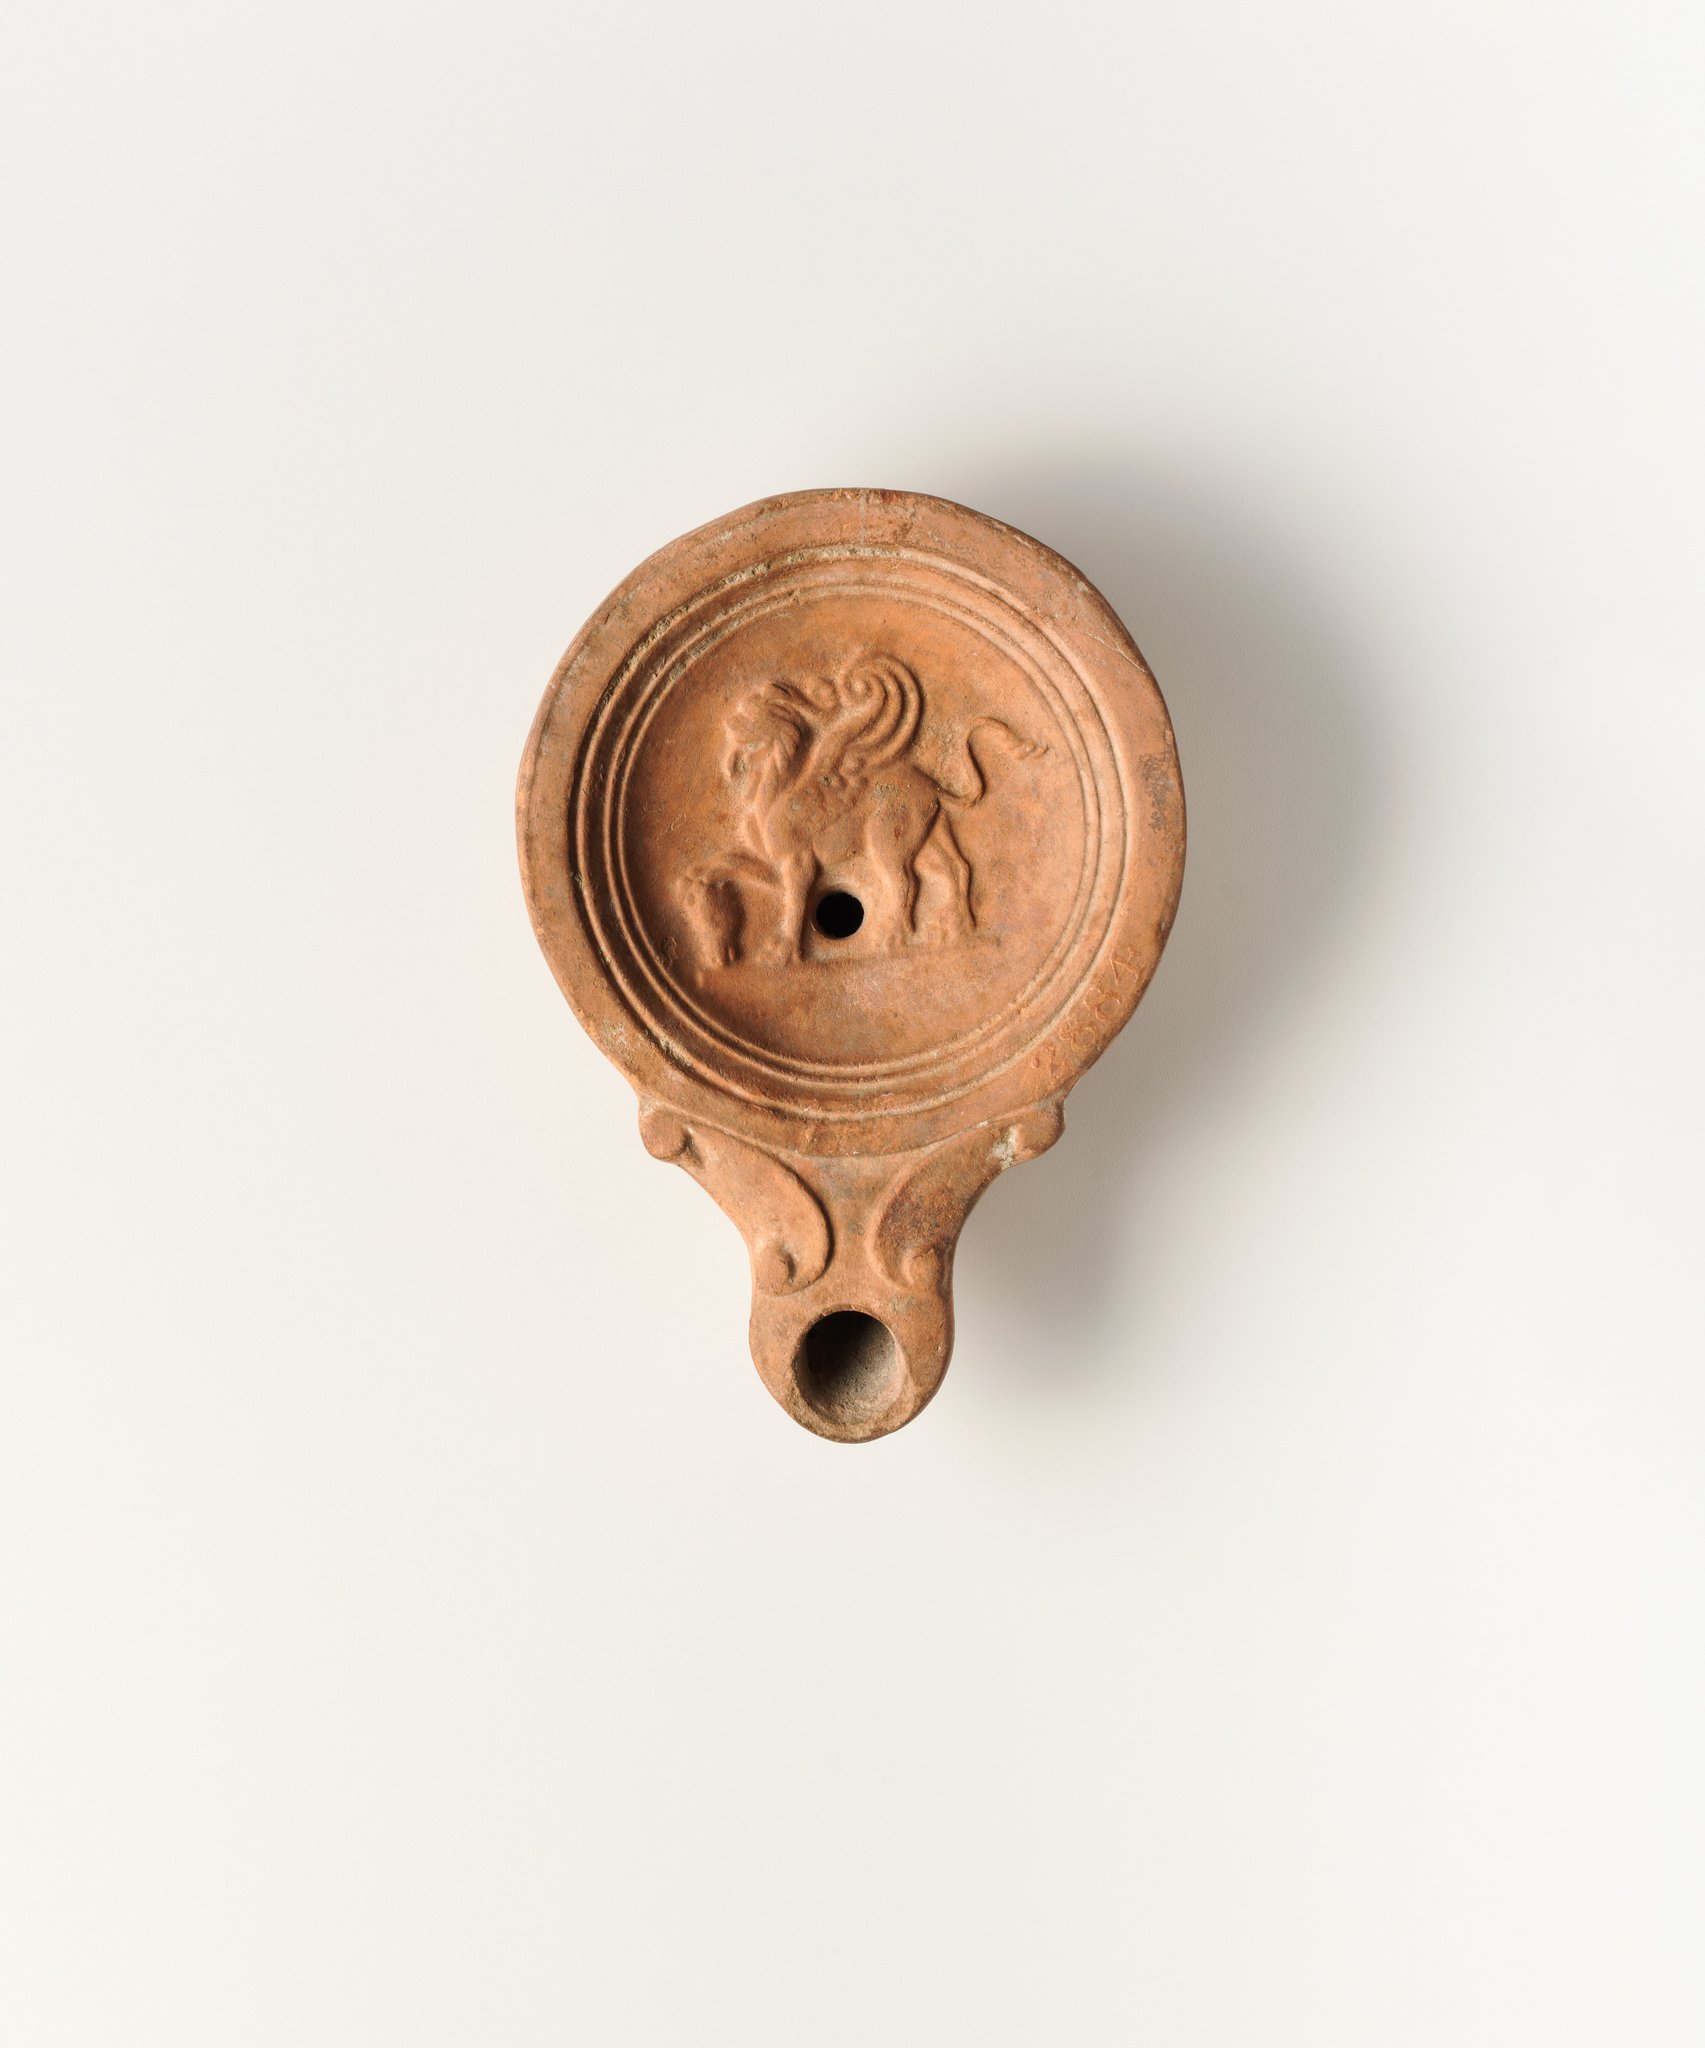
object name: lamp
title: Terracotta oil lamp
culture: roman, cypriot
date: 40-100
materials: terracotta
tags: griffins